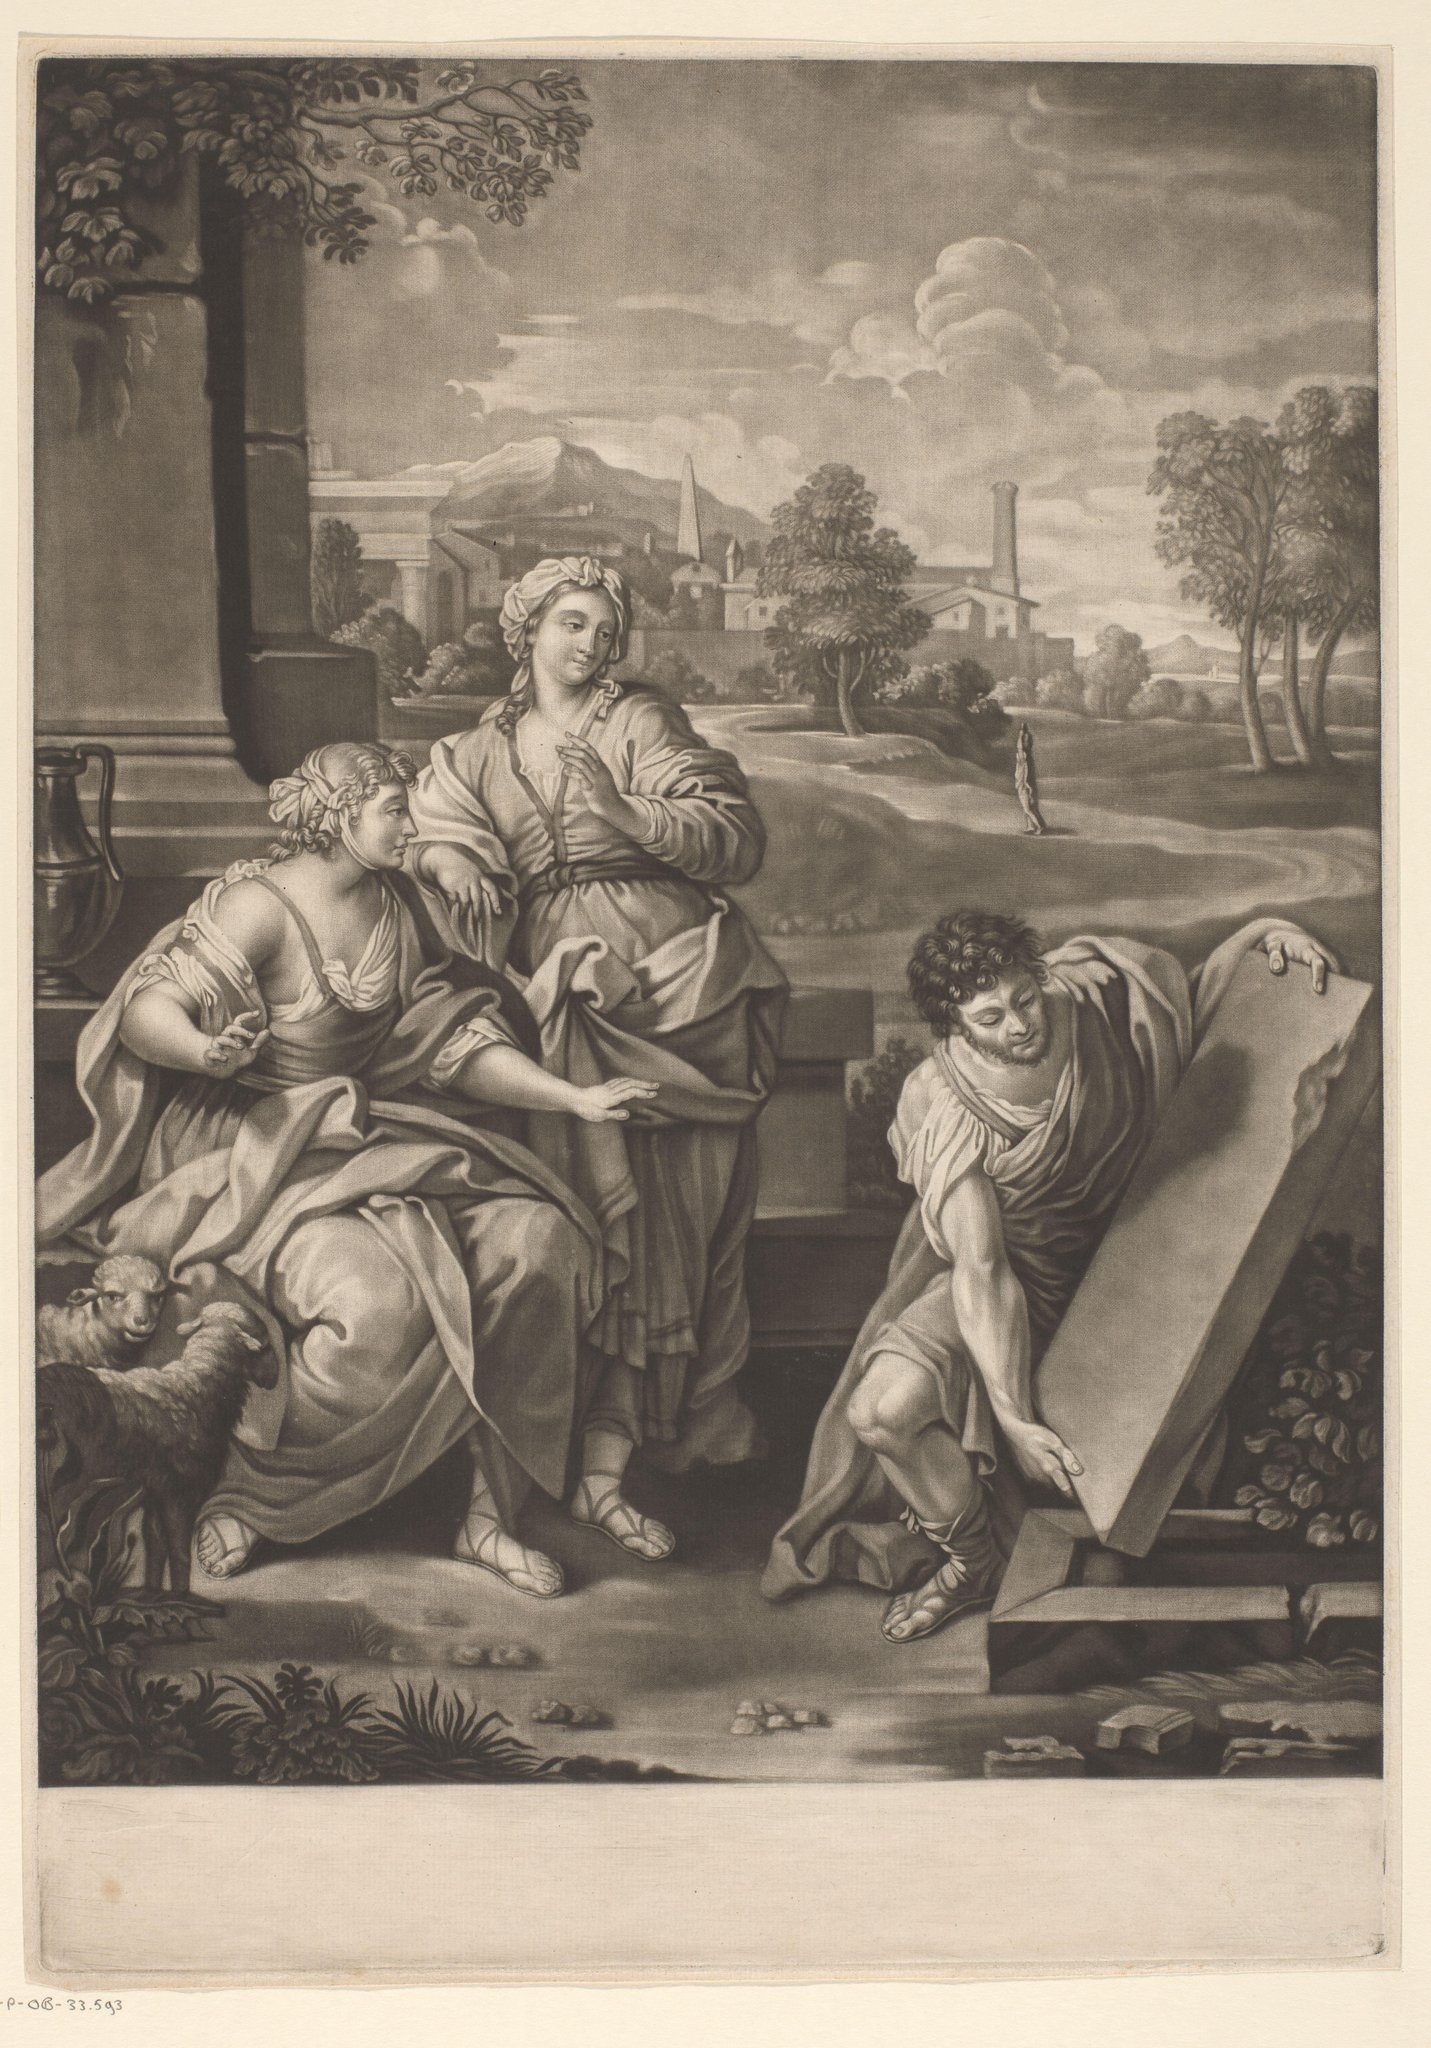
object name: print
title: Jakob tilt de steen van de put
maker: john finlayson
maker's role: print maker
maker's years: 1730-1776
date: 1772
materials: paper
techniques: mezzotint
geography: england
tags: jacob moves the stone which covers the opening of the well and waters rachel's sheep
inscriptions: collector's mark: Lugt 240